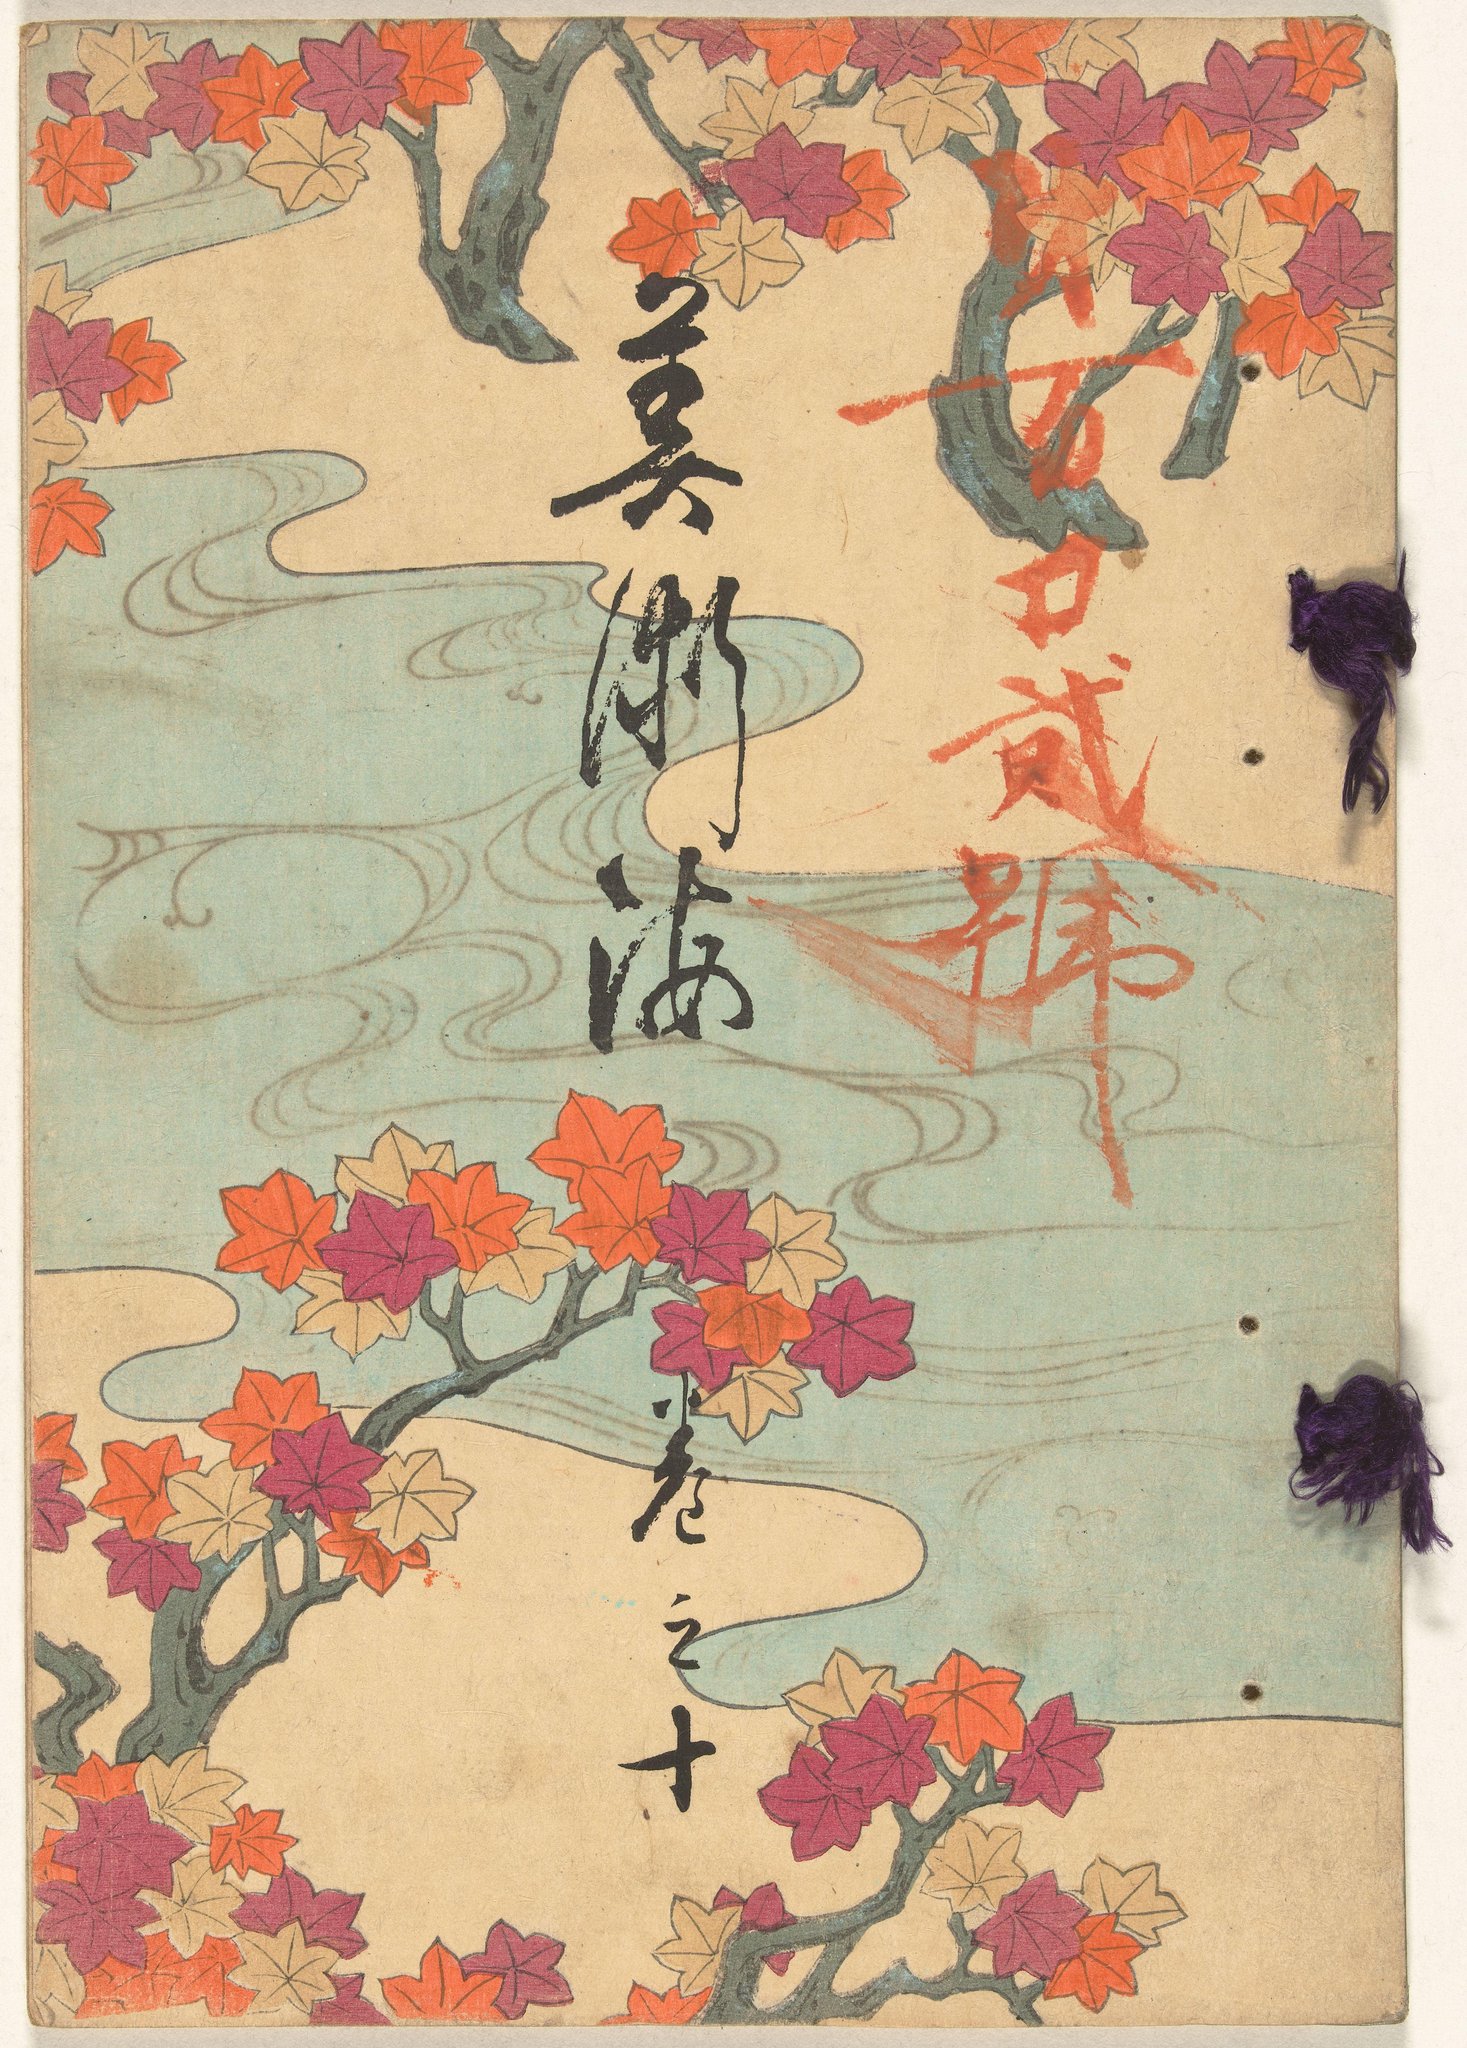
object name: book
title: Bijutsukai - kan no ju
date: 1896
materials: paper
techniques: woodcut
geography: kyoto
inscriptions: date